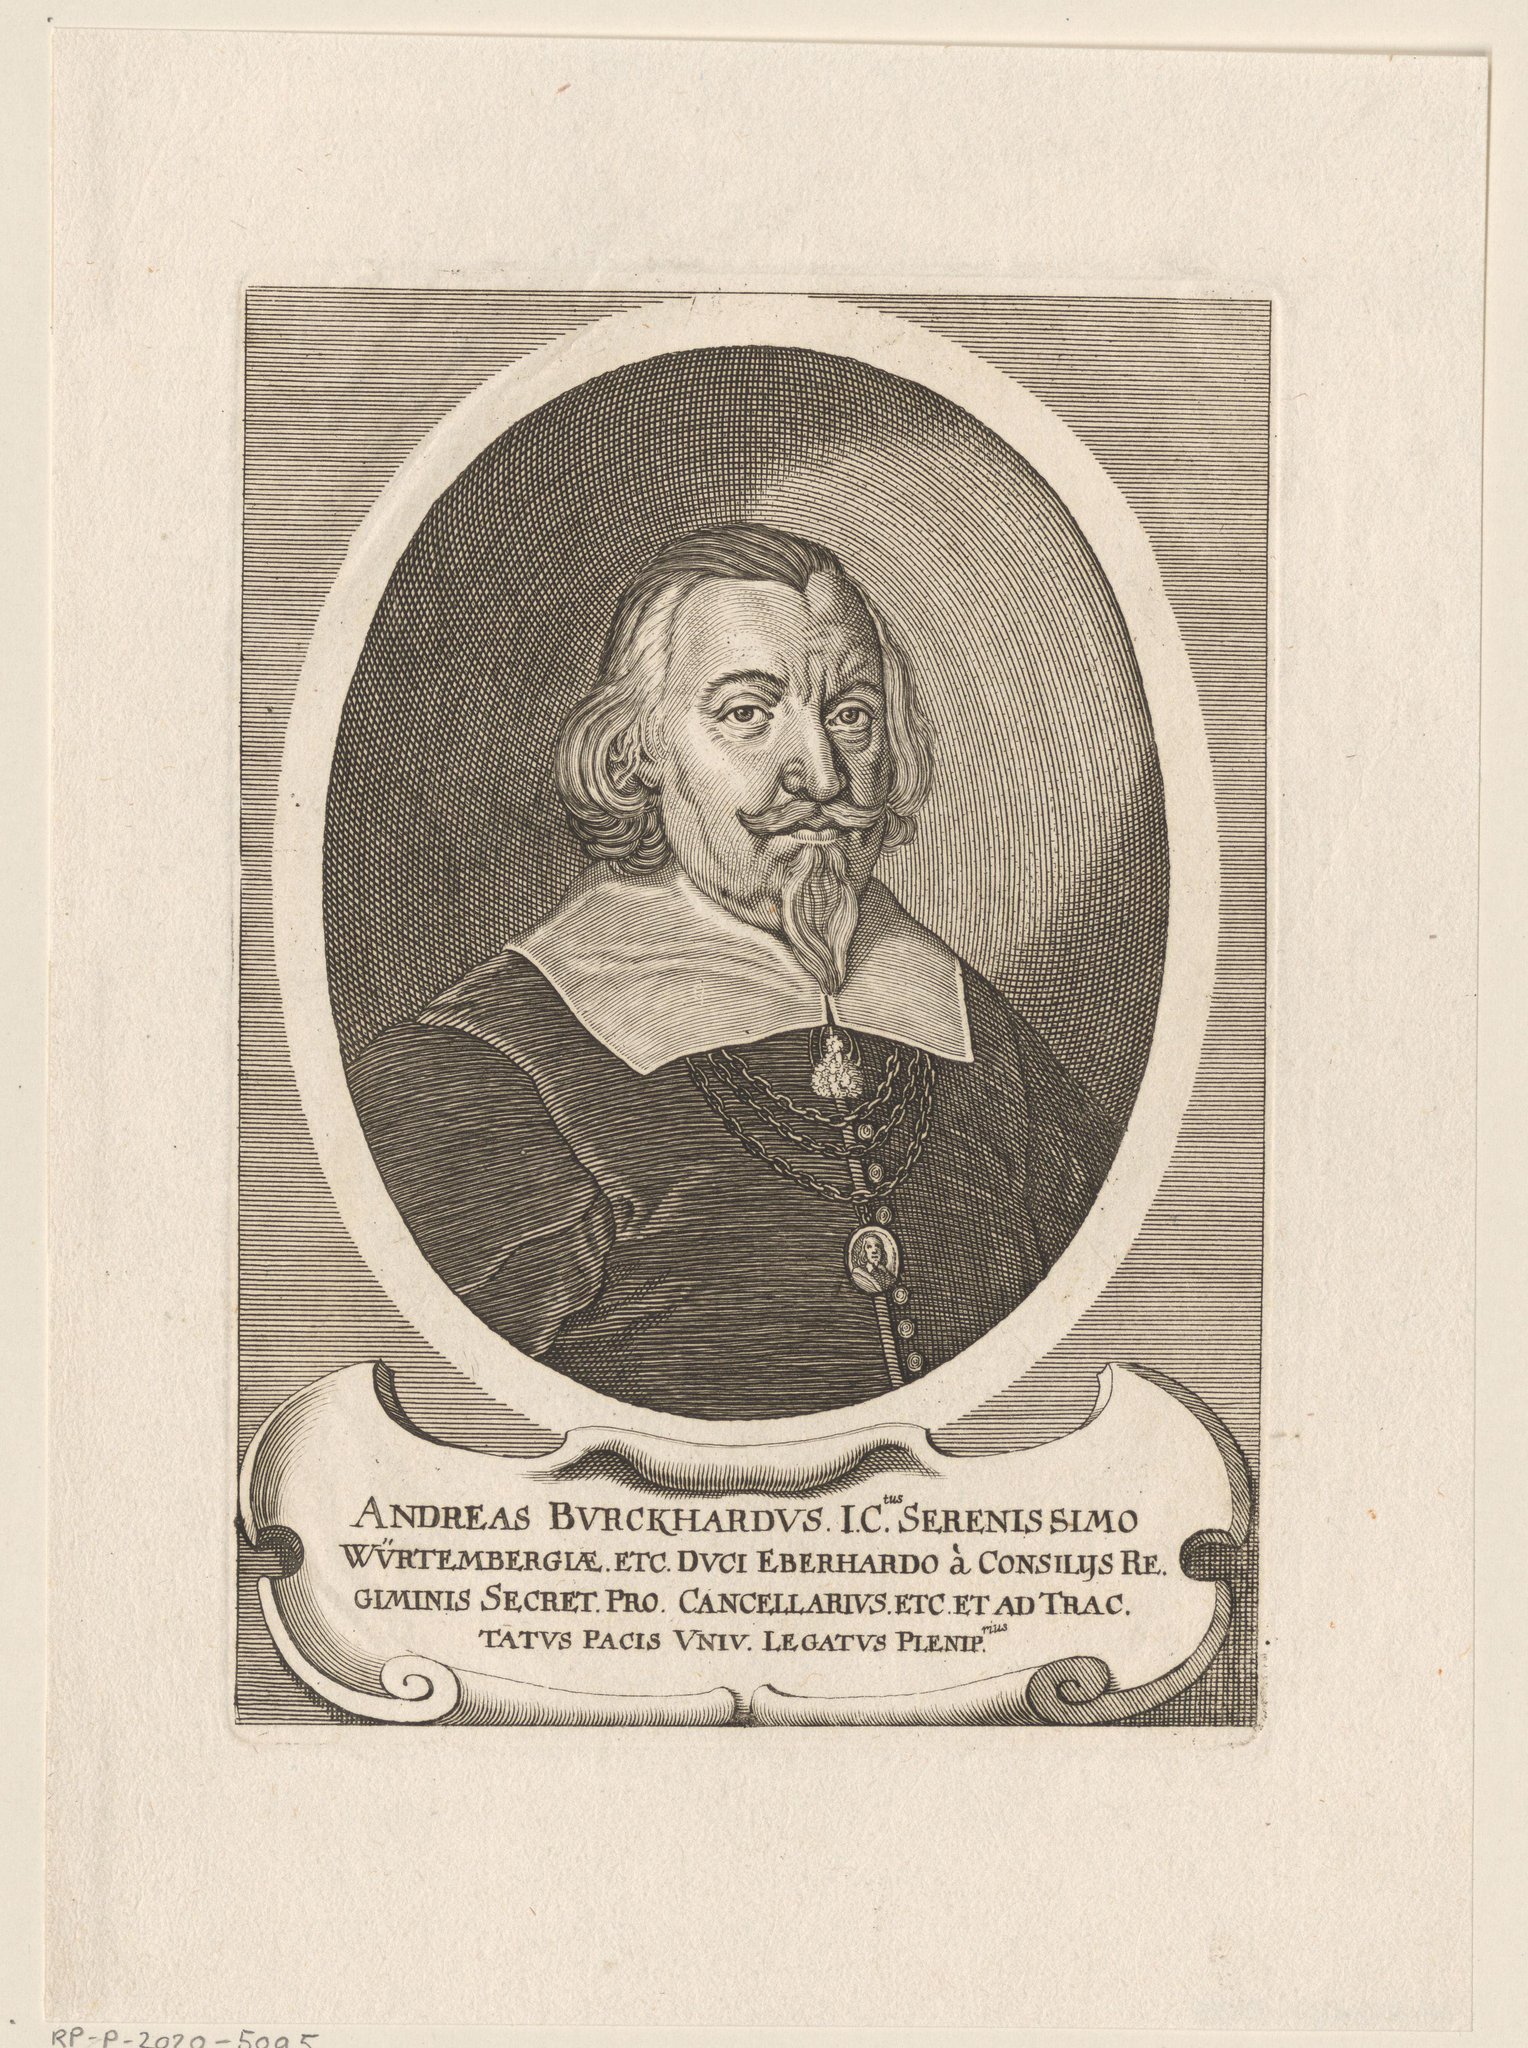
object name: print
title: Portret van Andreas Burckhardt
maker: Anonymous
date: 1650-1699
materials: paper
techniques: engraving, etching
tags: politician, historical persons, politician, e.g. party leader